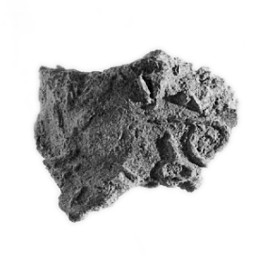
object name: sealing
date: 1981-1640 BCE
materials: mud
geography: egypt